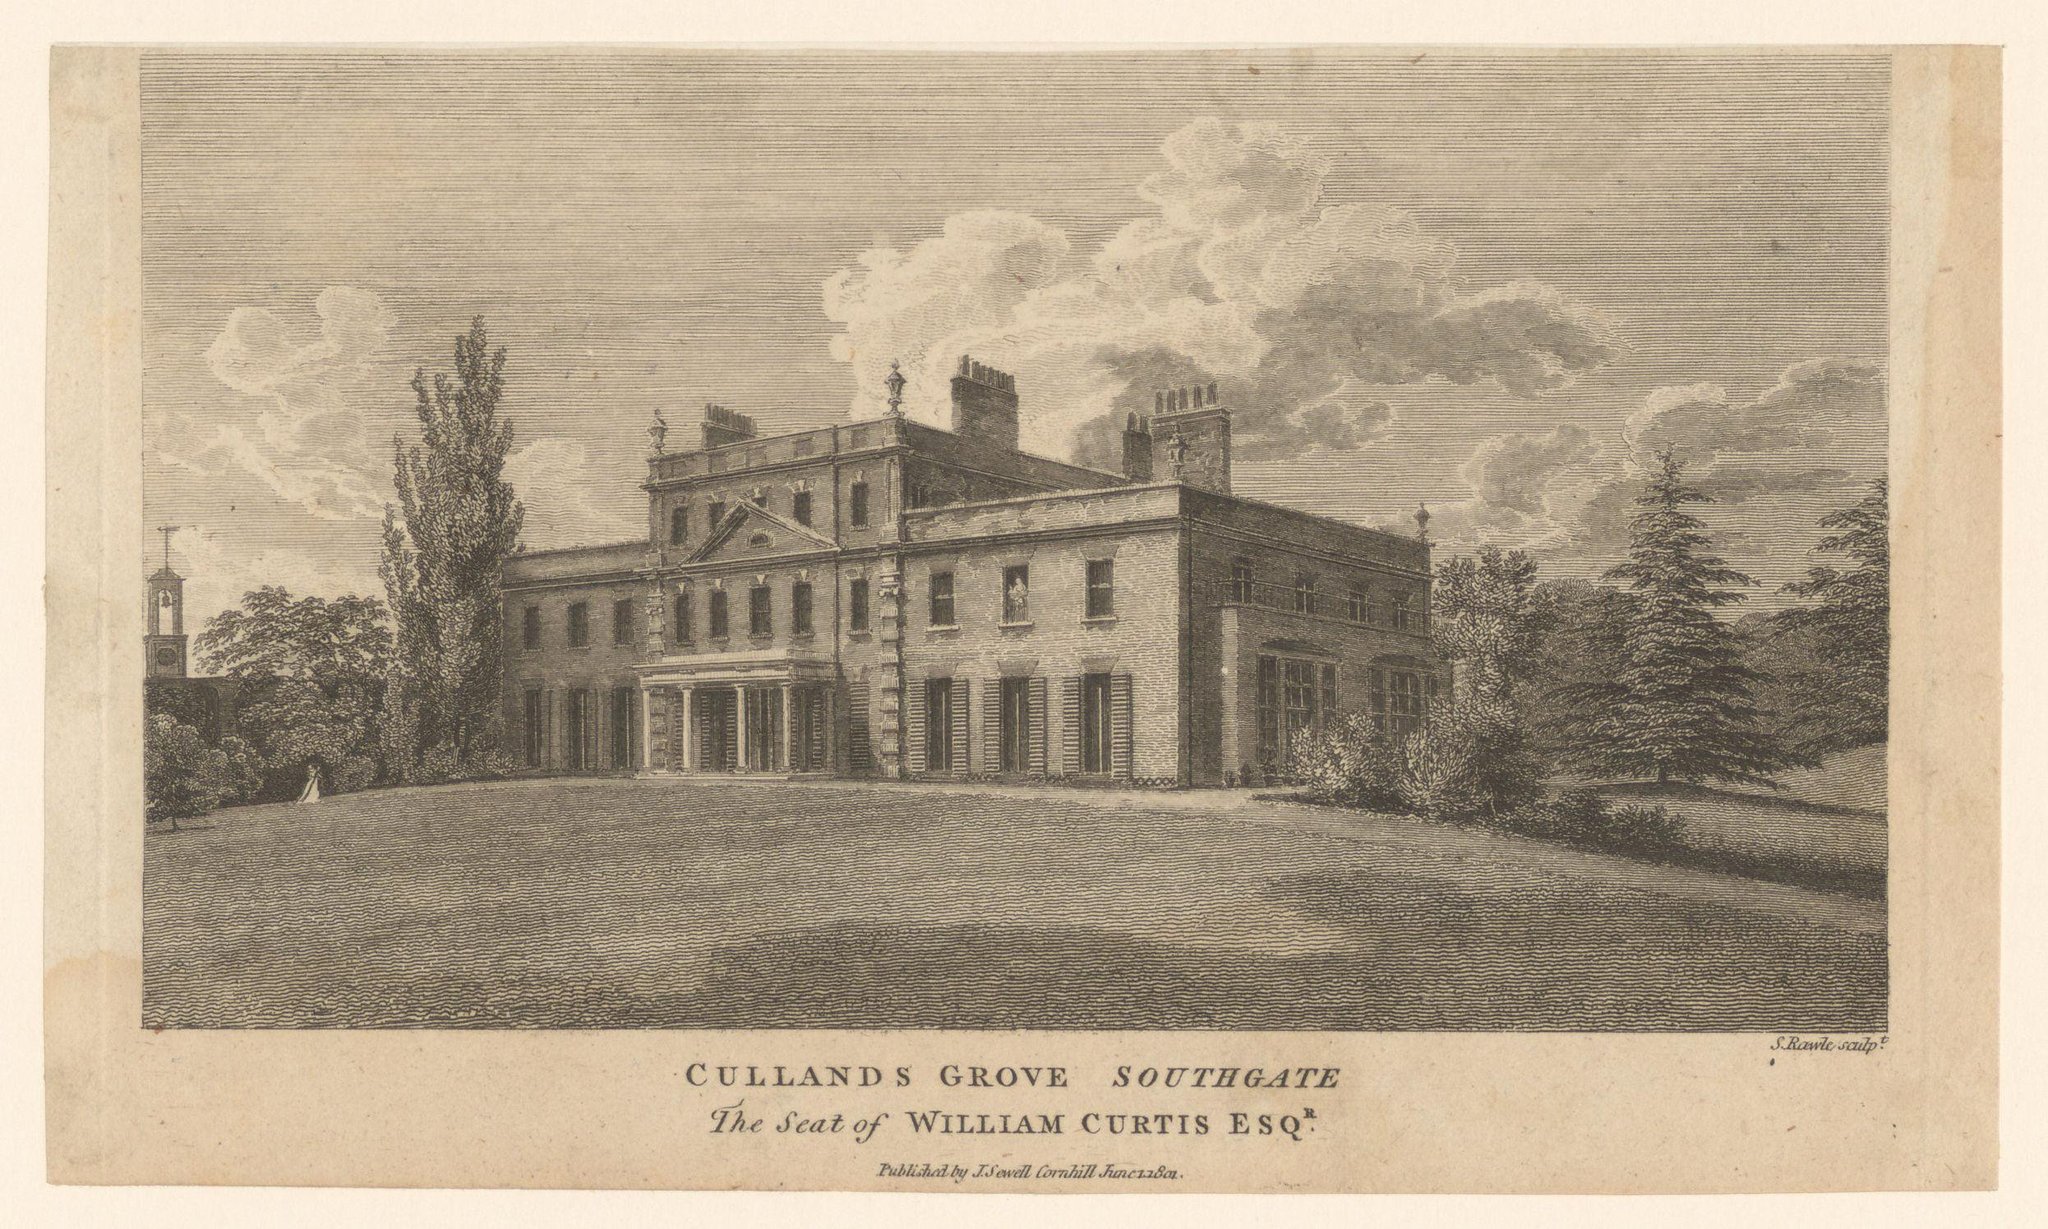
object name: print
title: Villa in een landschap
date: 1801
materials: paper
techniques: etching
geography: london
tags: country-house, london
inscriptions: collector's mark: Lugt 2228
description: Prent gebruikt in: European Magazine, 1801.